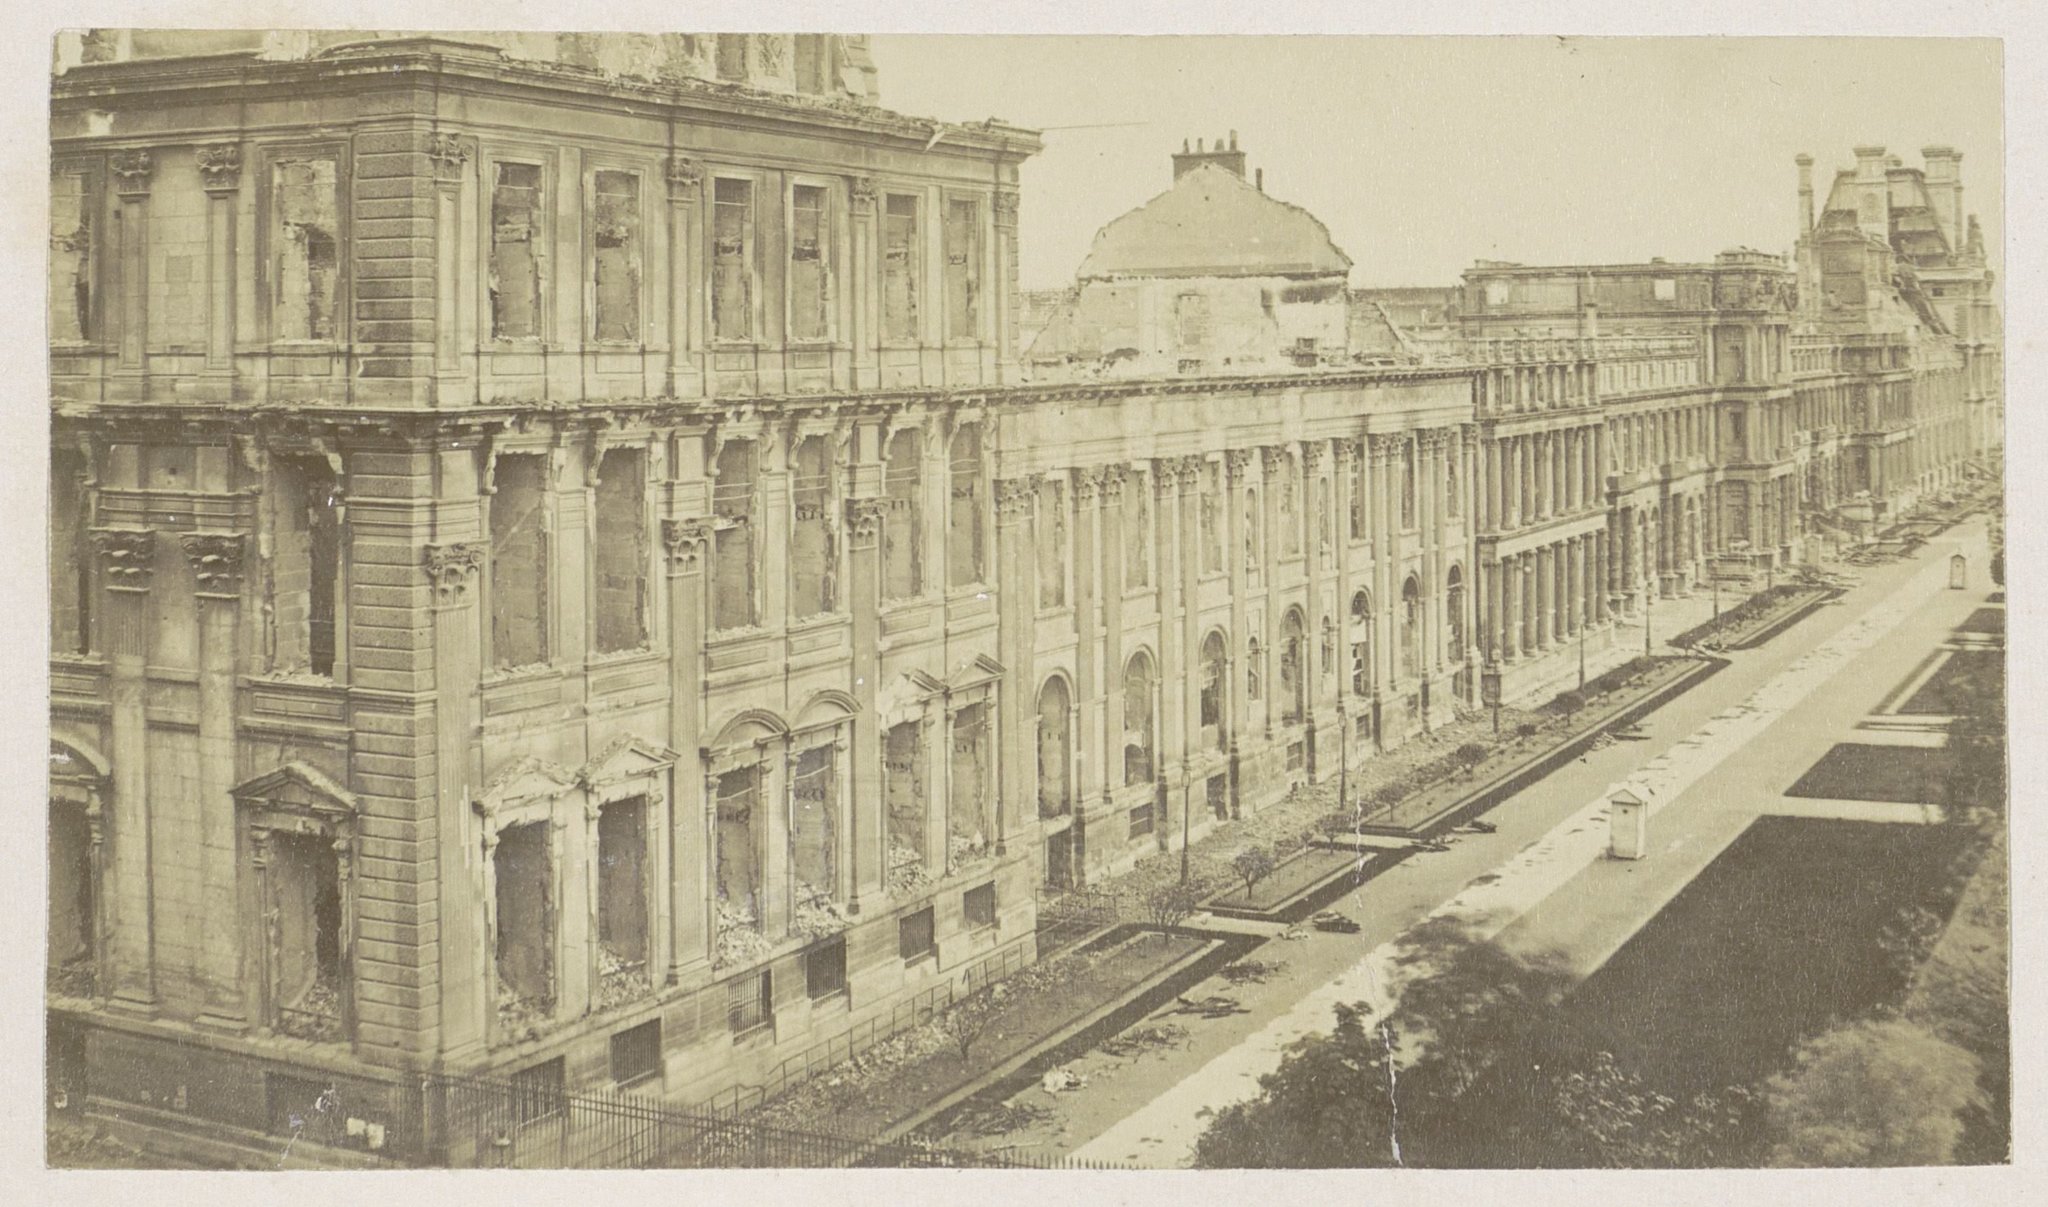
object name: photograph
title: Ruïne van het Pavillon de Marsan bij het Palais des Tuileries in Parijs, na de verwoesting tijdens de Commune in 1871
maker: Anonymous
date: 1871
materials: photographic support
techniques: albumen print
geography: paris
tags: façade (of house or building), ruin of a dwelling, house, castle, etc., paris, tuileries palace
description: Onderdeel van Reisalbum Europese steden, vermoedelijk Zweeds.